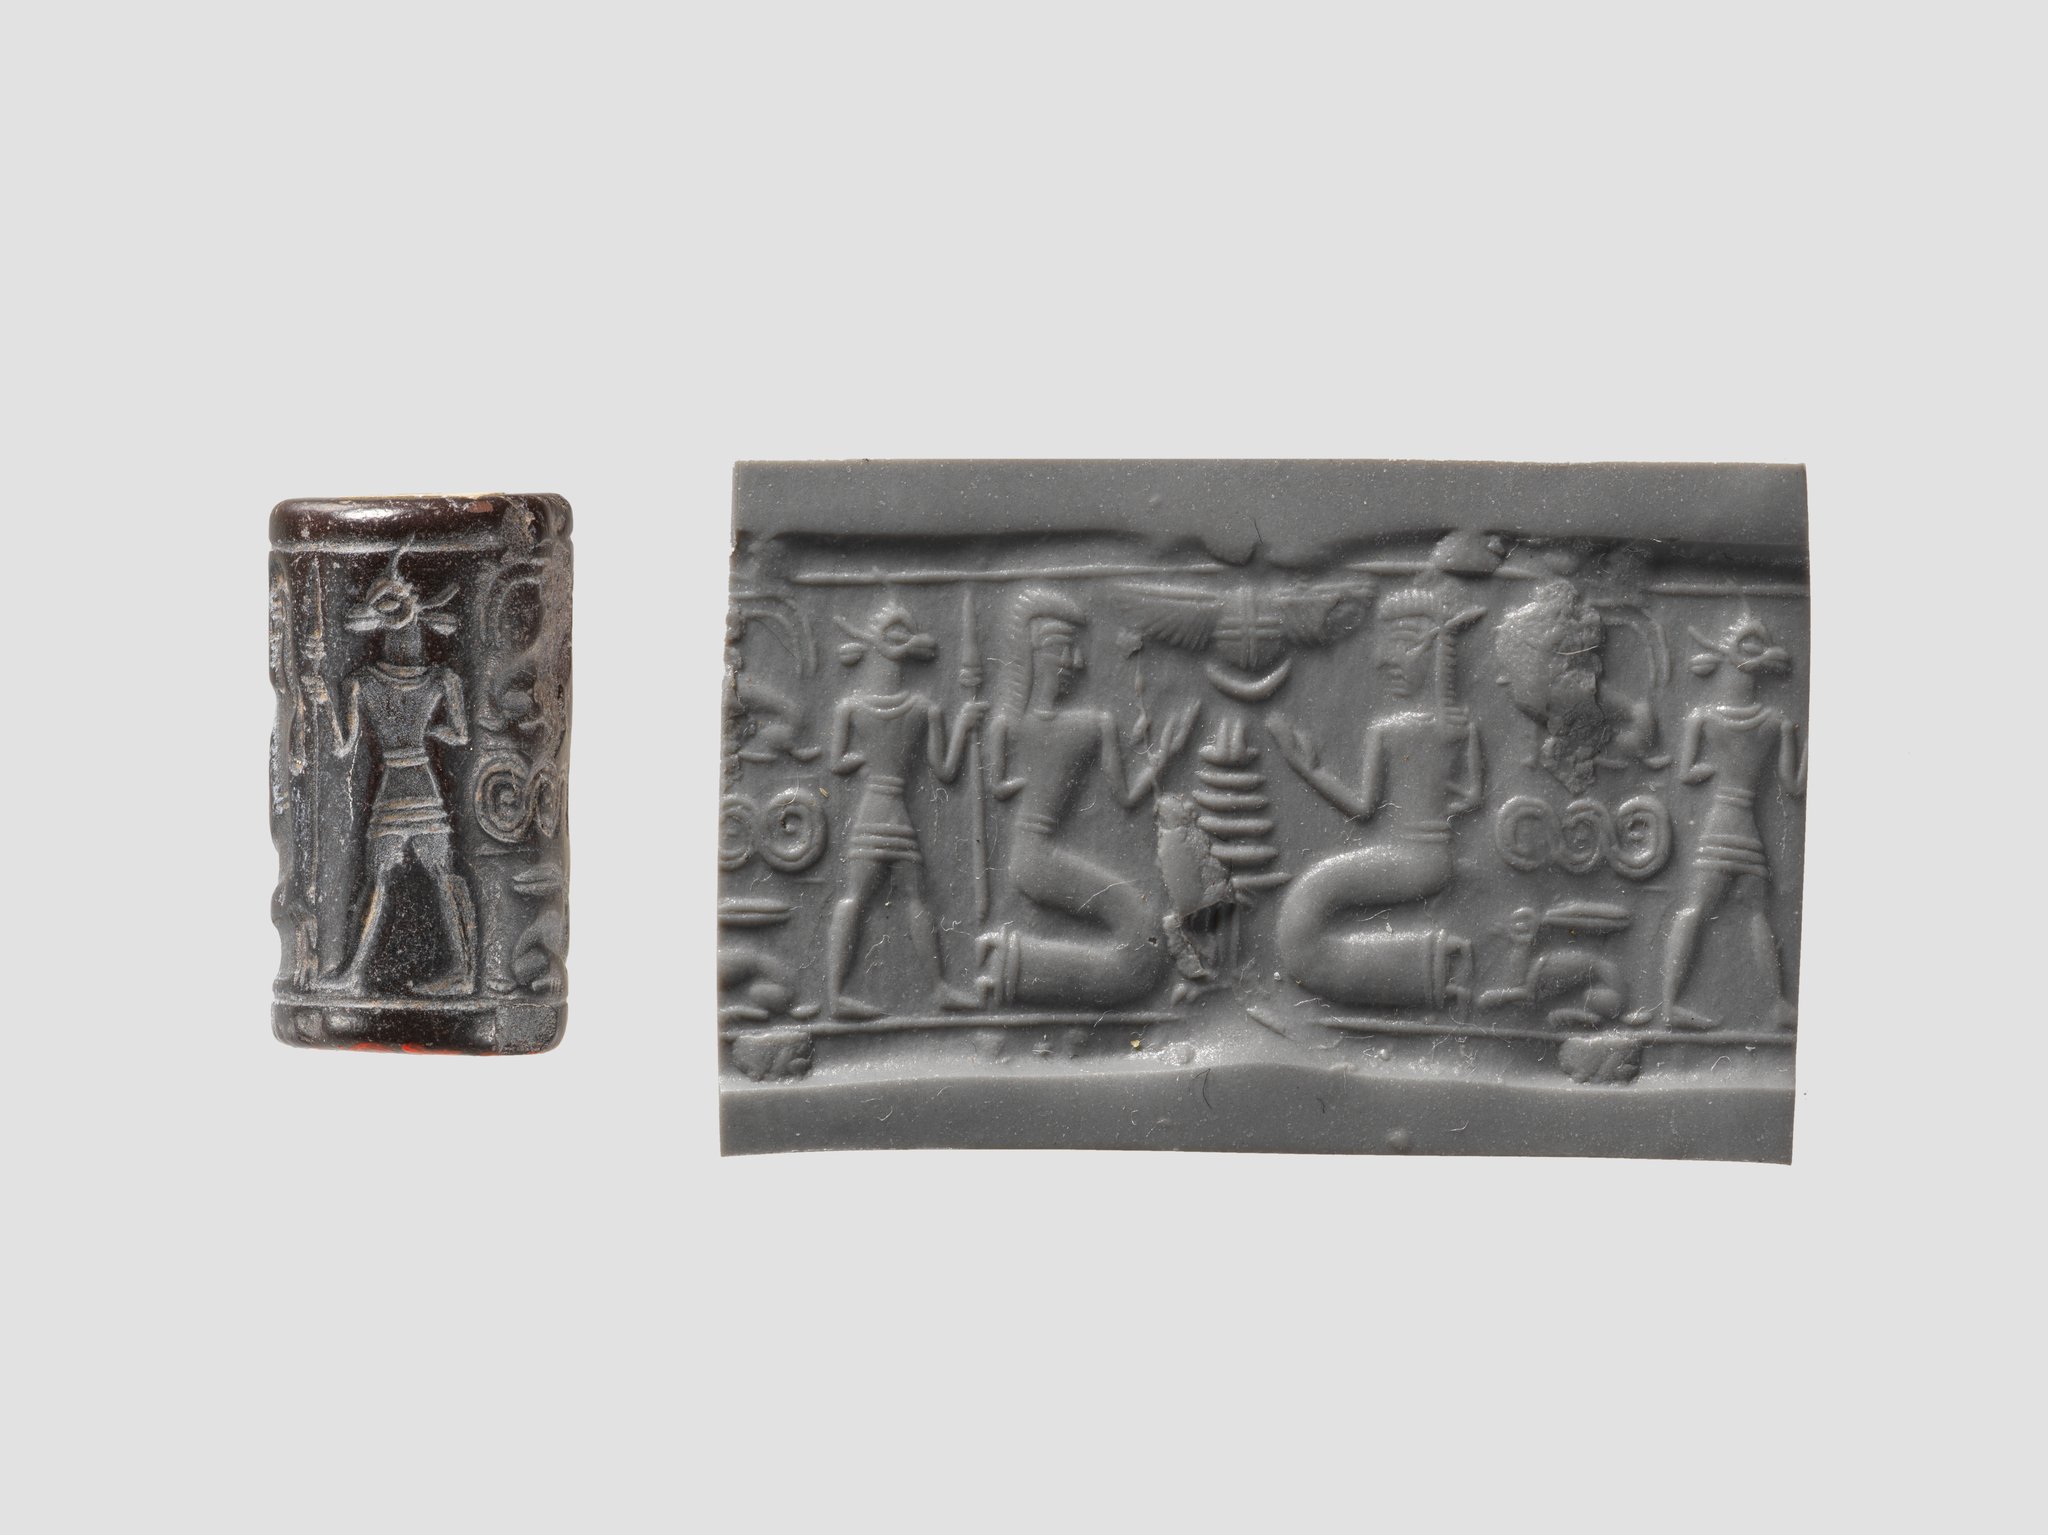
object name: cylinder seal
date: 1820-1730 BCE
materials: mineral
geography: syria